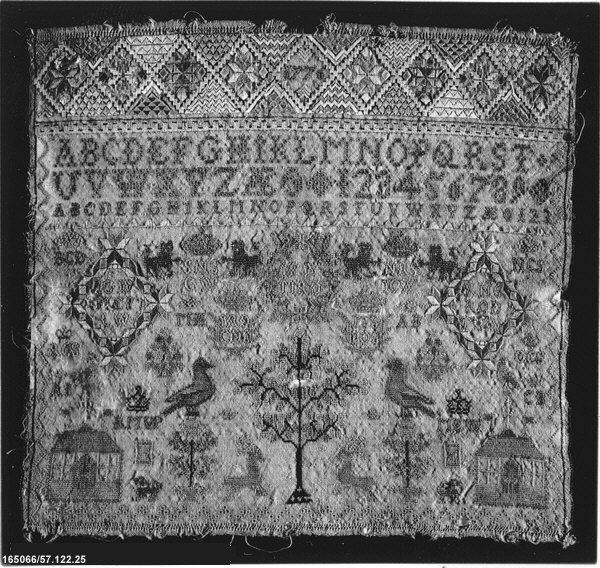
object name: sampler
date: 1776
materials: canvas, silk, wool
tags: birds,flowers,trees